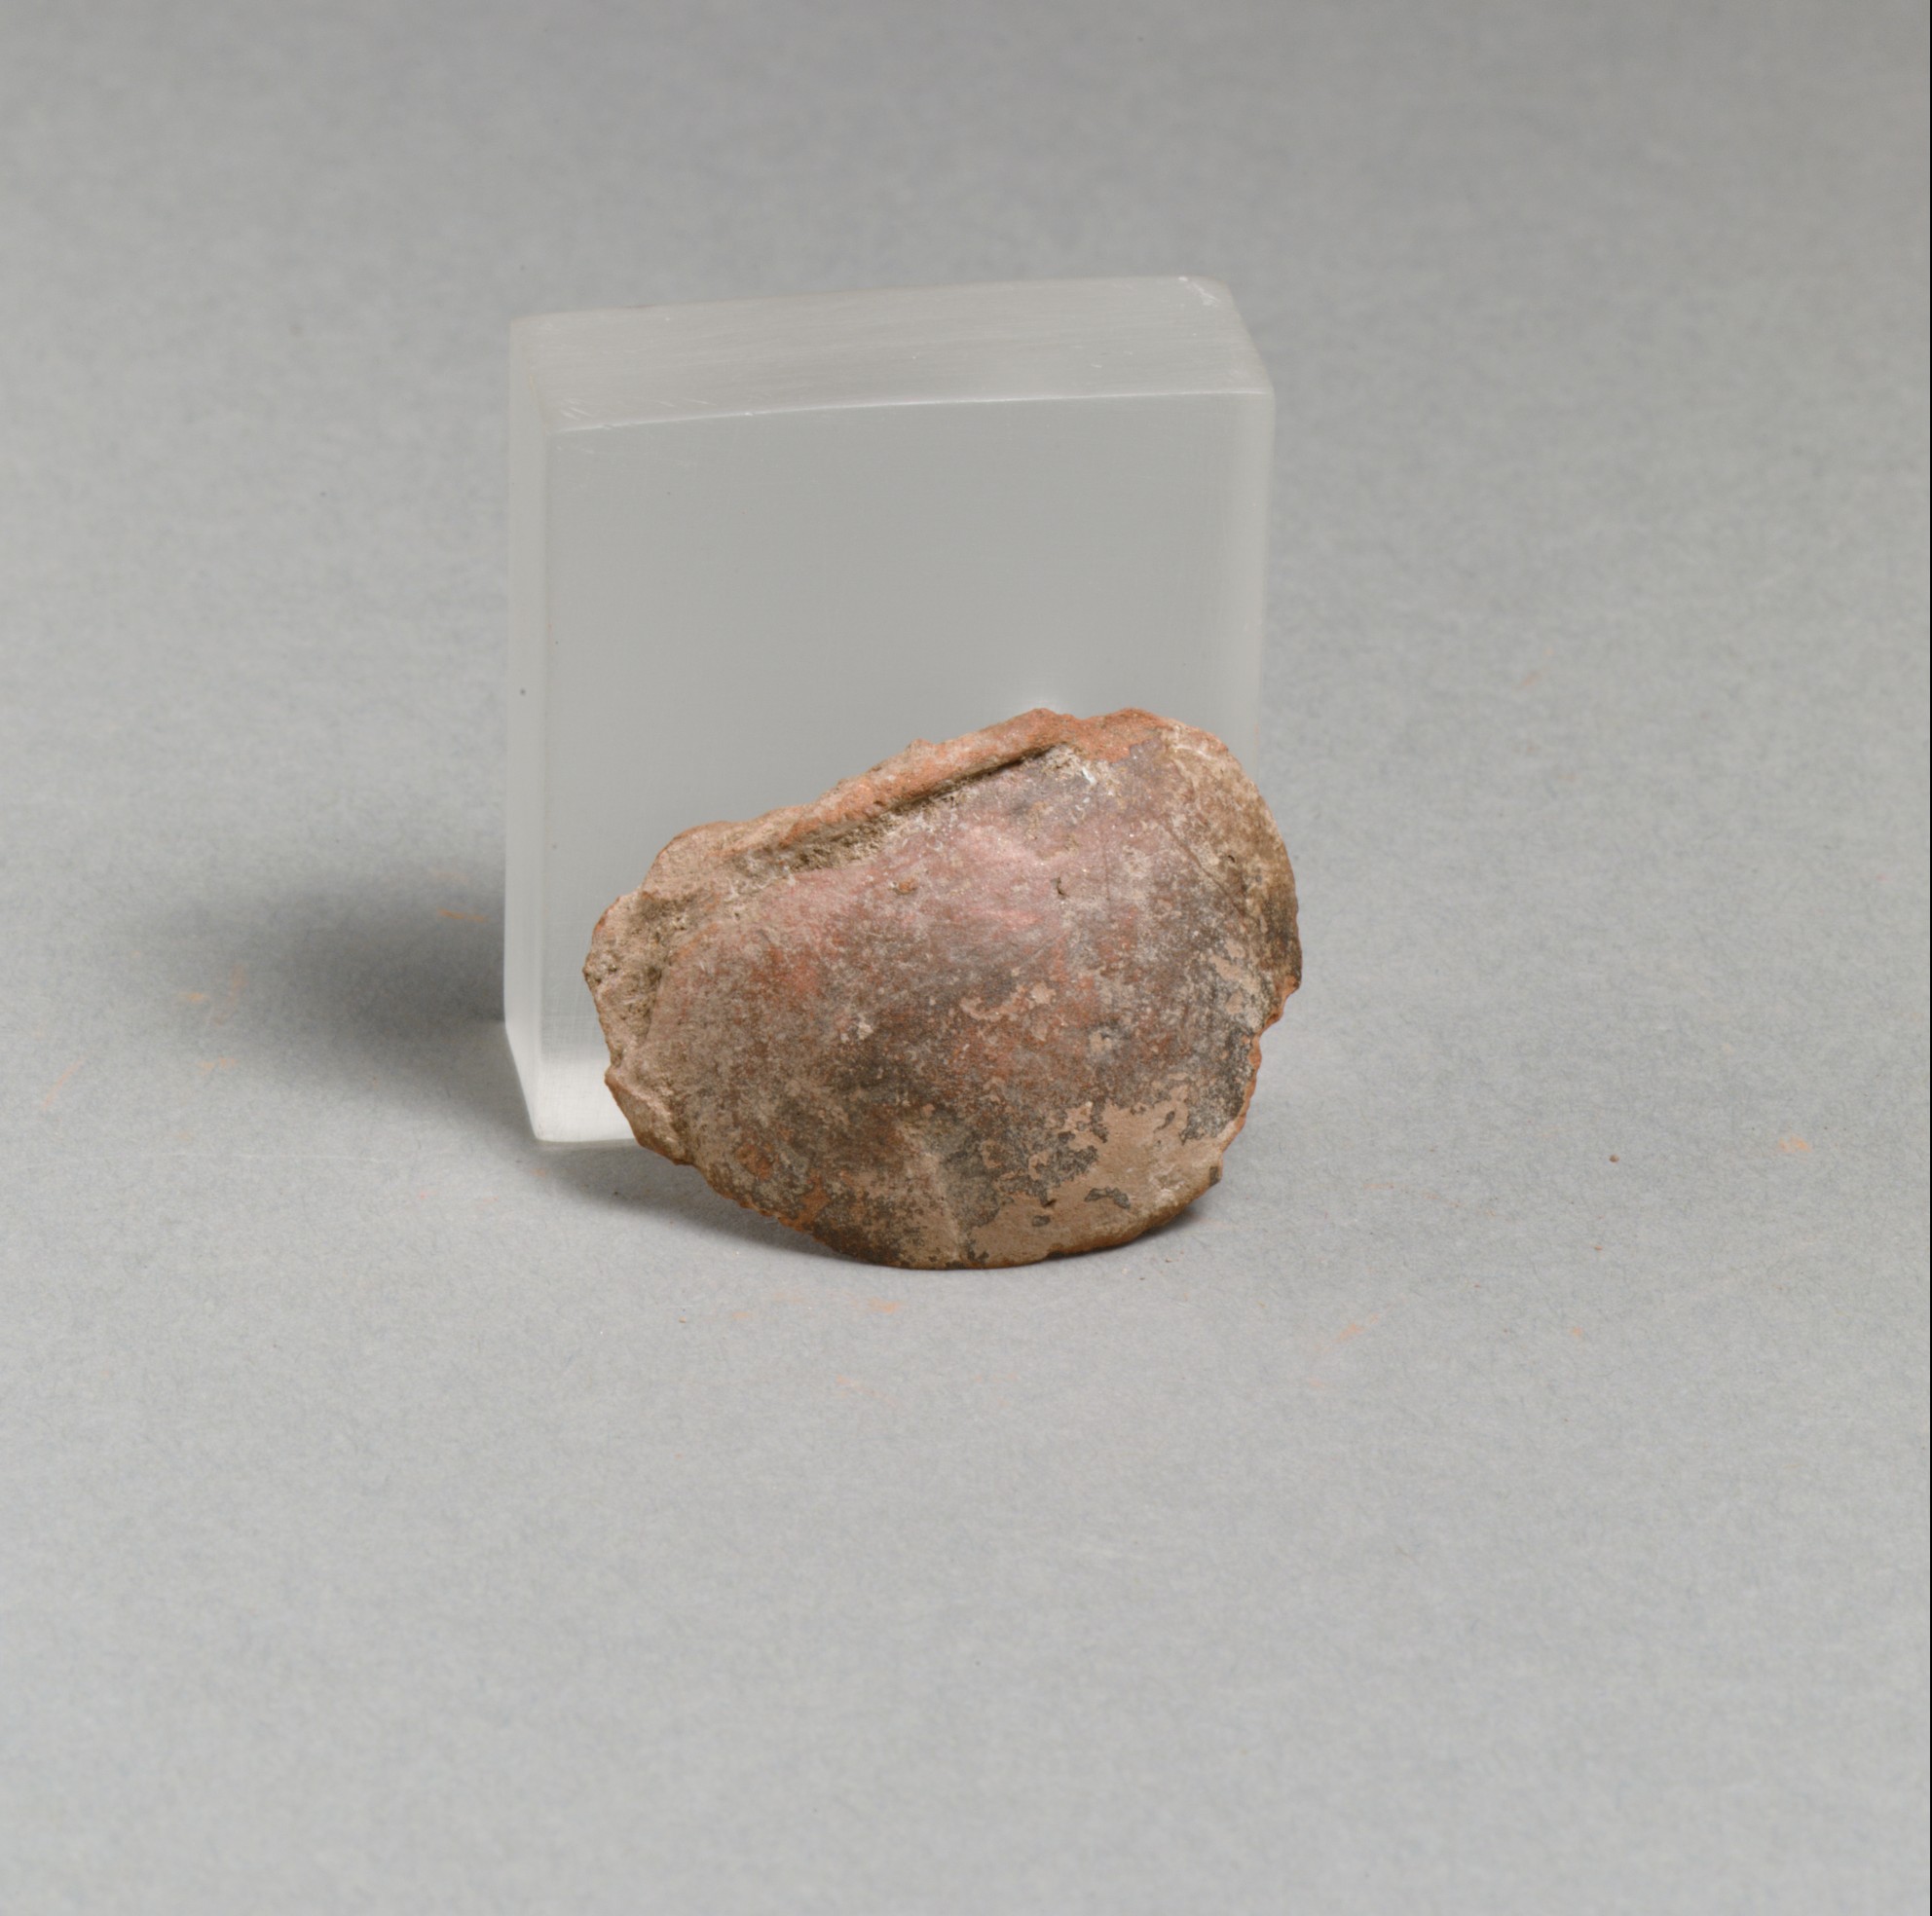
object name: vase fragment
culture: greek or lydian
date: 1050-700 BCE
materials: terracotta